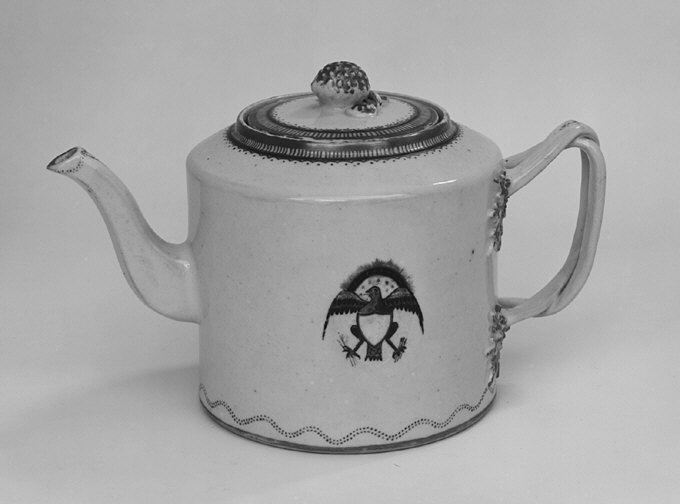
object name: teapot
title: Teapot (part of a service)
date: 1767-1833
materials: hard paste porcelain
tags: birds,insignia